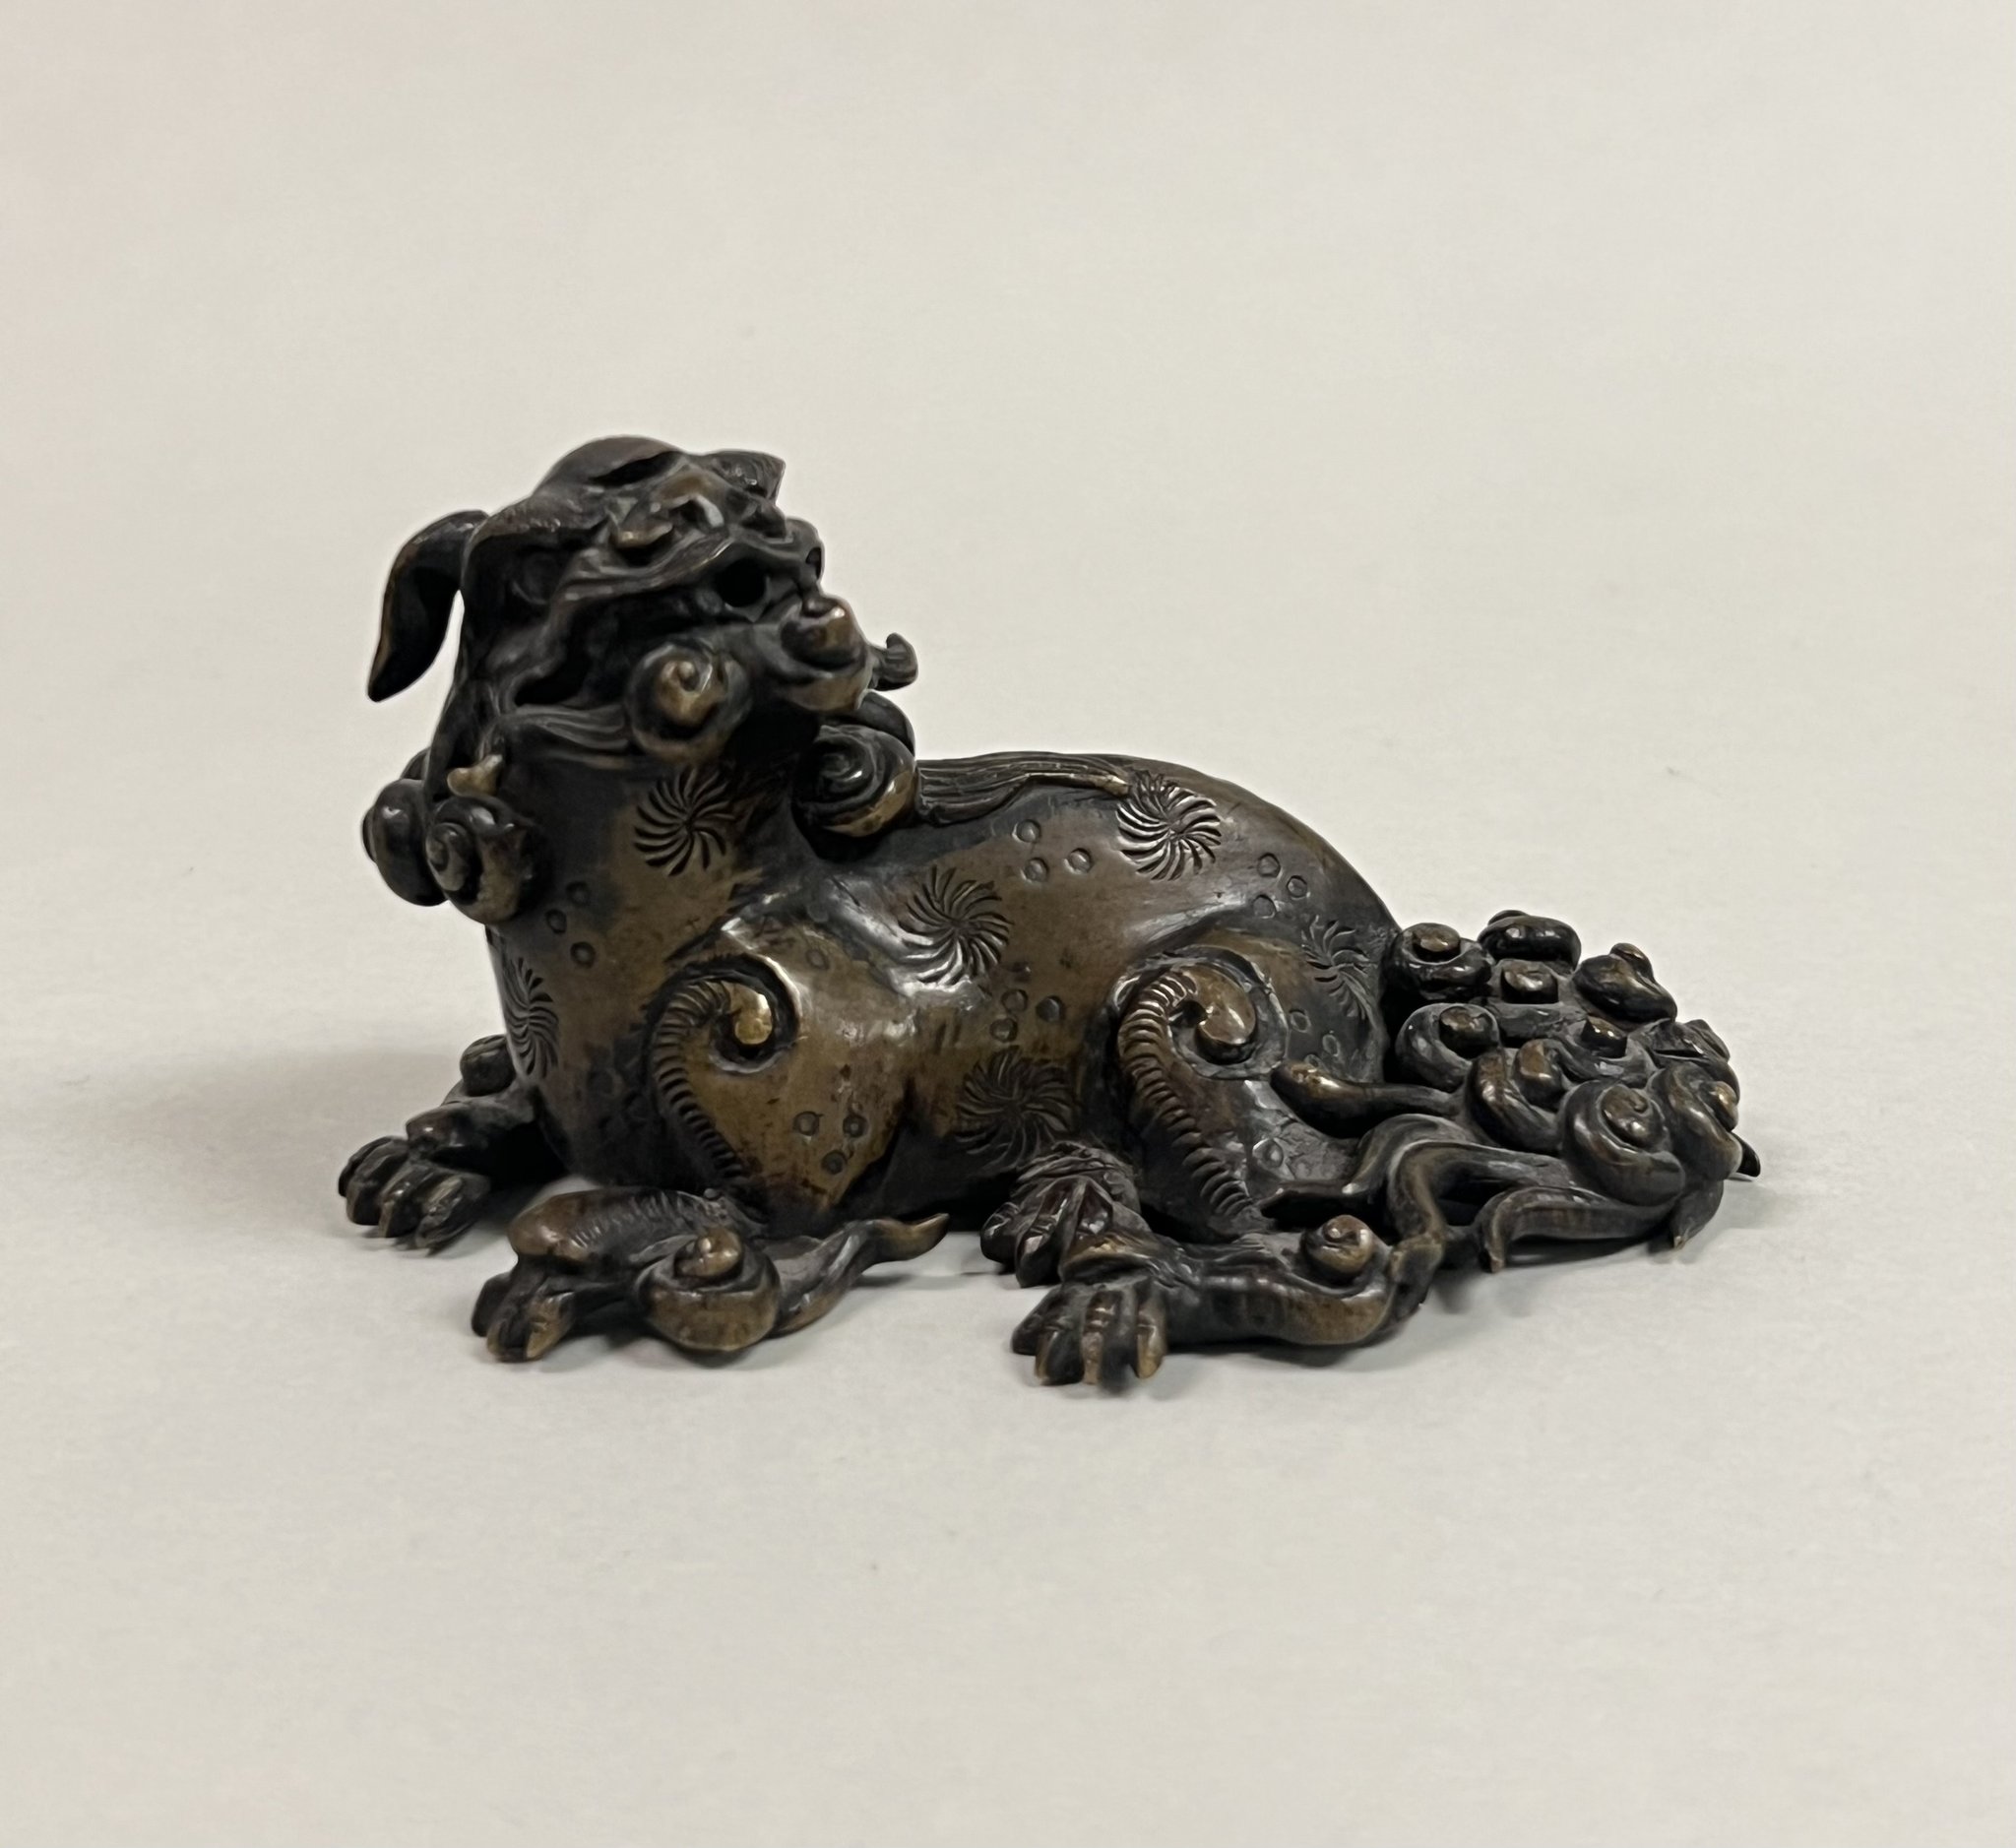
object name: water dropper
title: Waterdropper in shape of a lion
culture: chinese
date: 1368-1644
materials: bronze